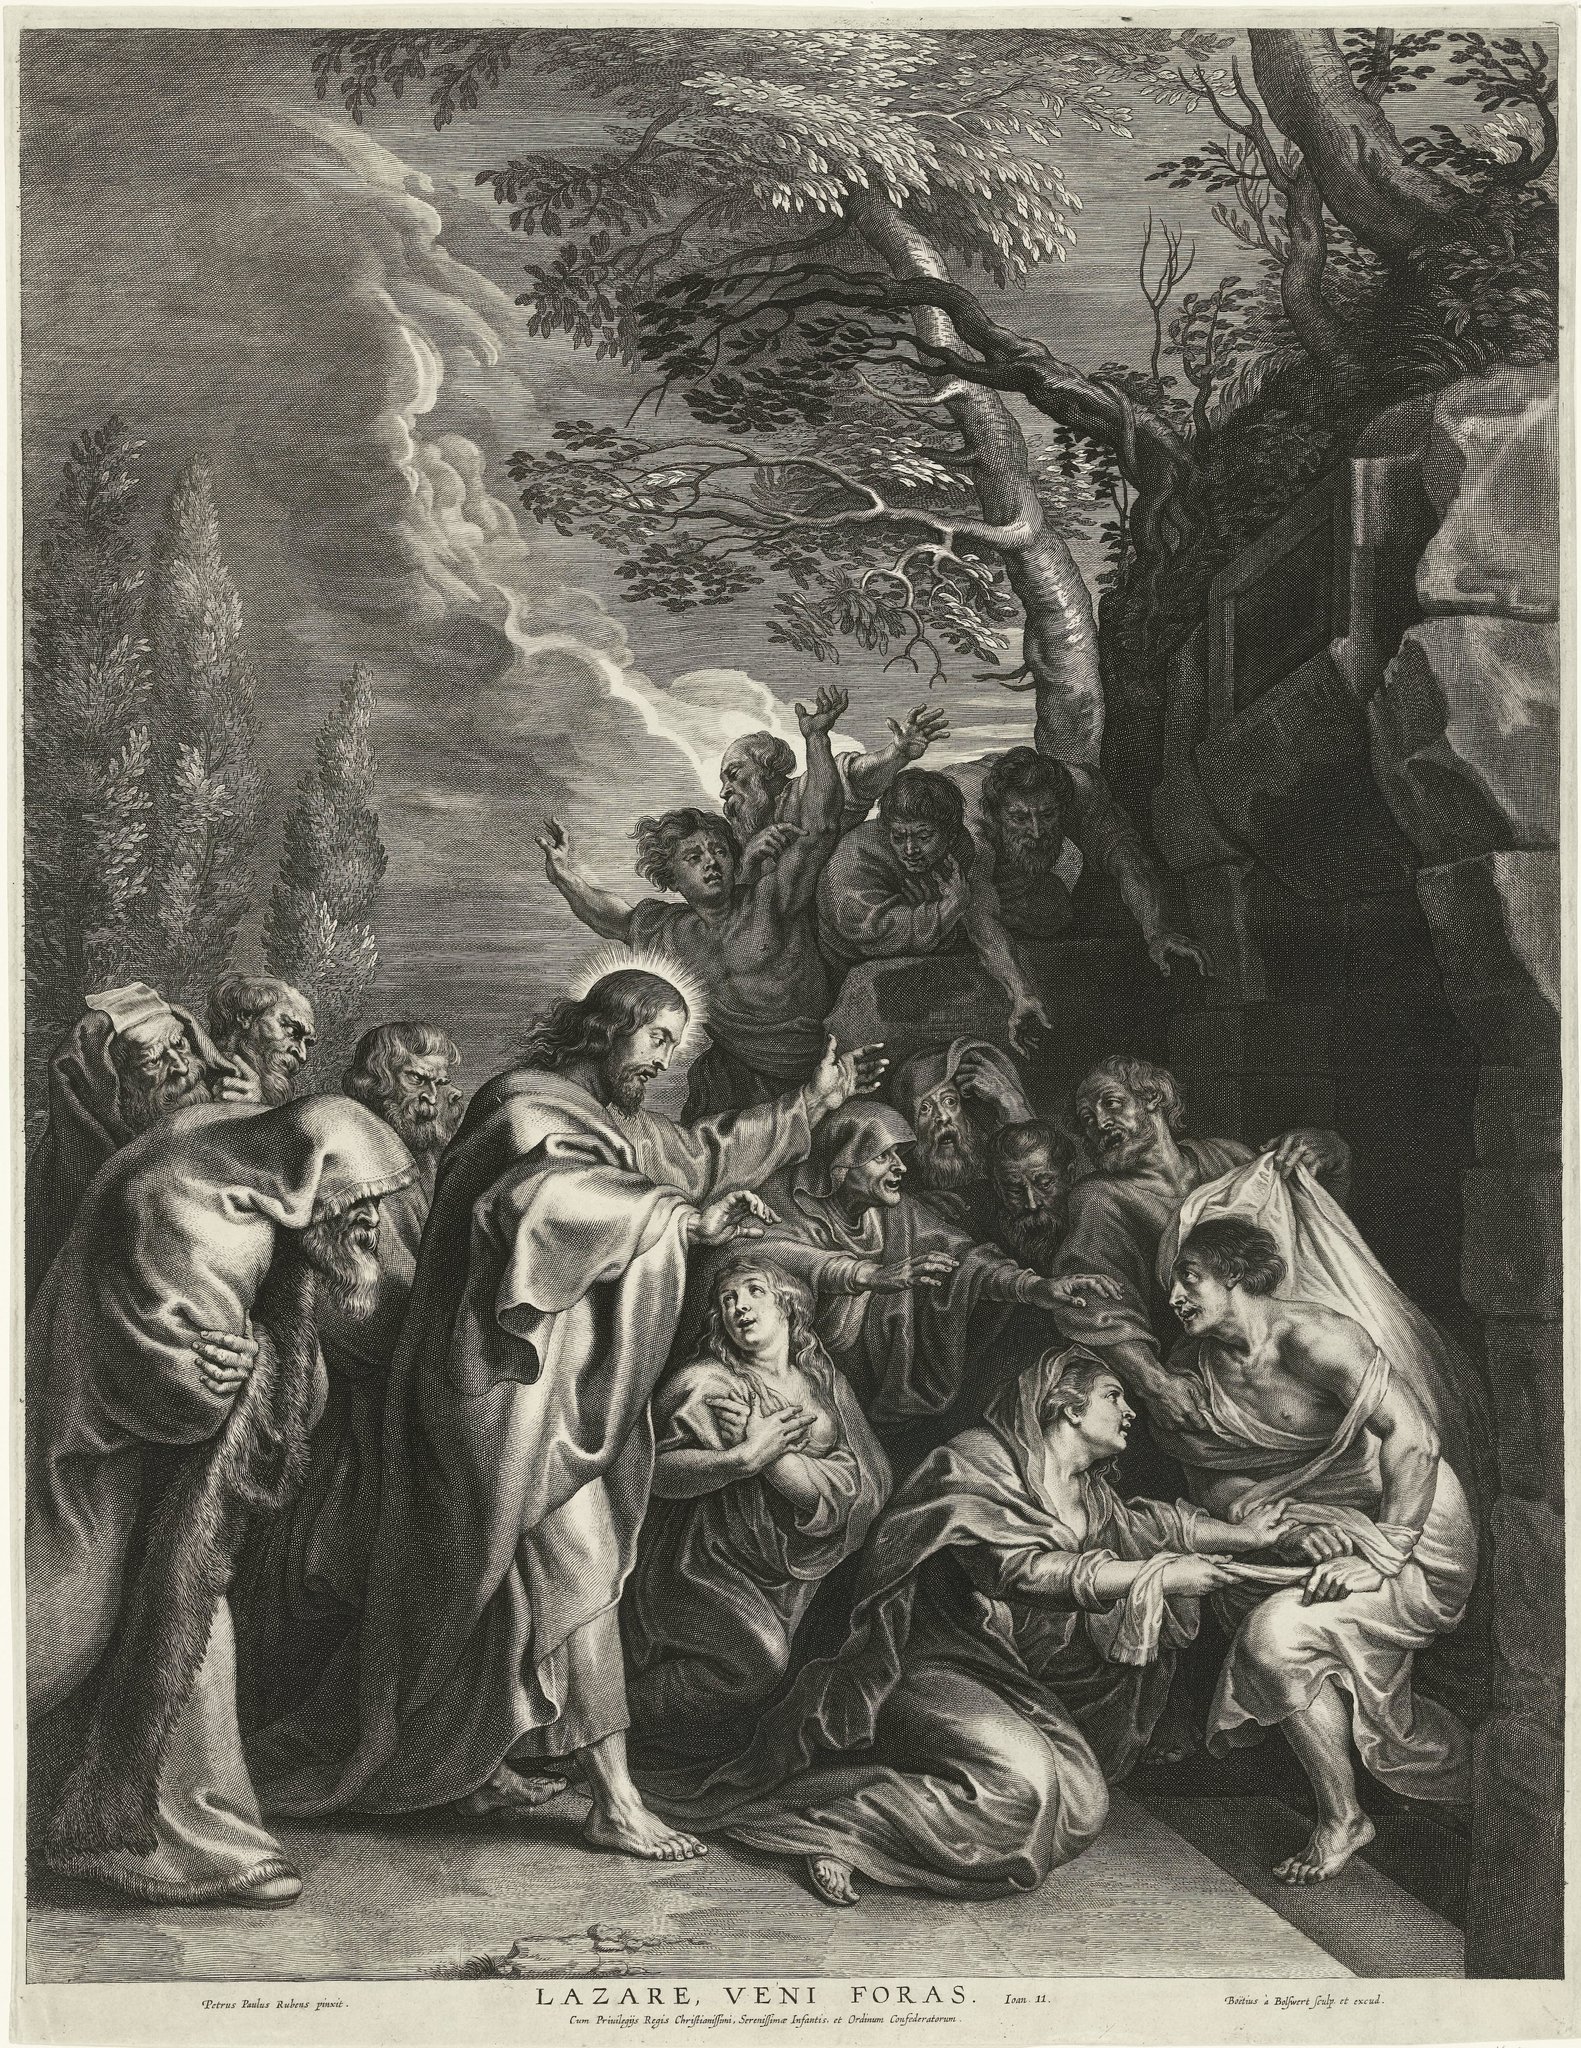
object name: print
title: Opwekking van Lazarus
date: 1590-1633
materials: paper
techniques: engraving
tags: the raising of lazarus ('lazarus, come out')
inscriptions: collector's mark: Lugt 240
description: Opwekking van Lazarus, een wonder verricht door Christus (Joh 11).